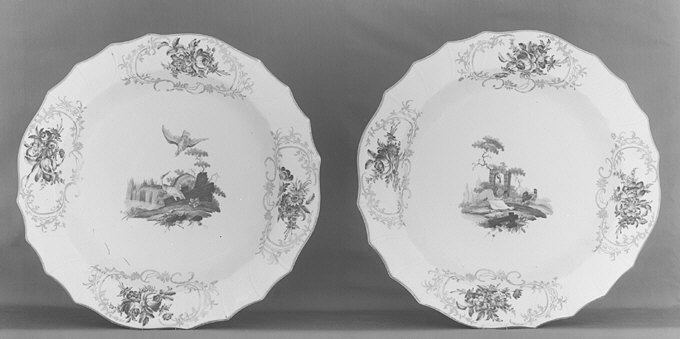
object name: plate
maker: tournai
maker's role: factory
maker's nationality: belgian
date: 1776-1781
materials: soft paste porcelain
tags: birds,trees